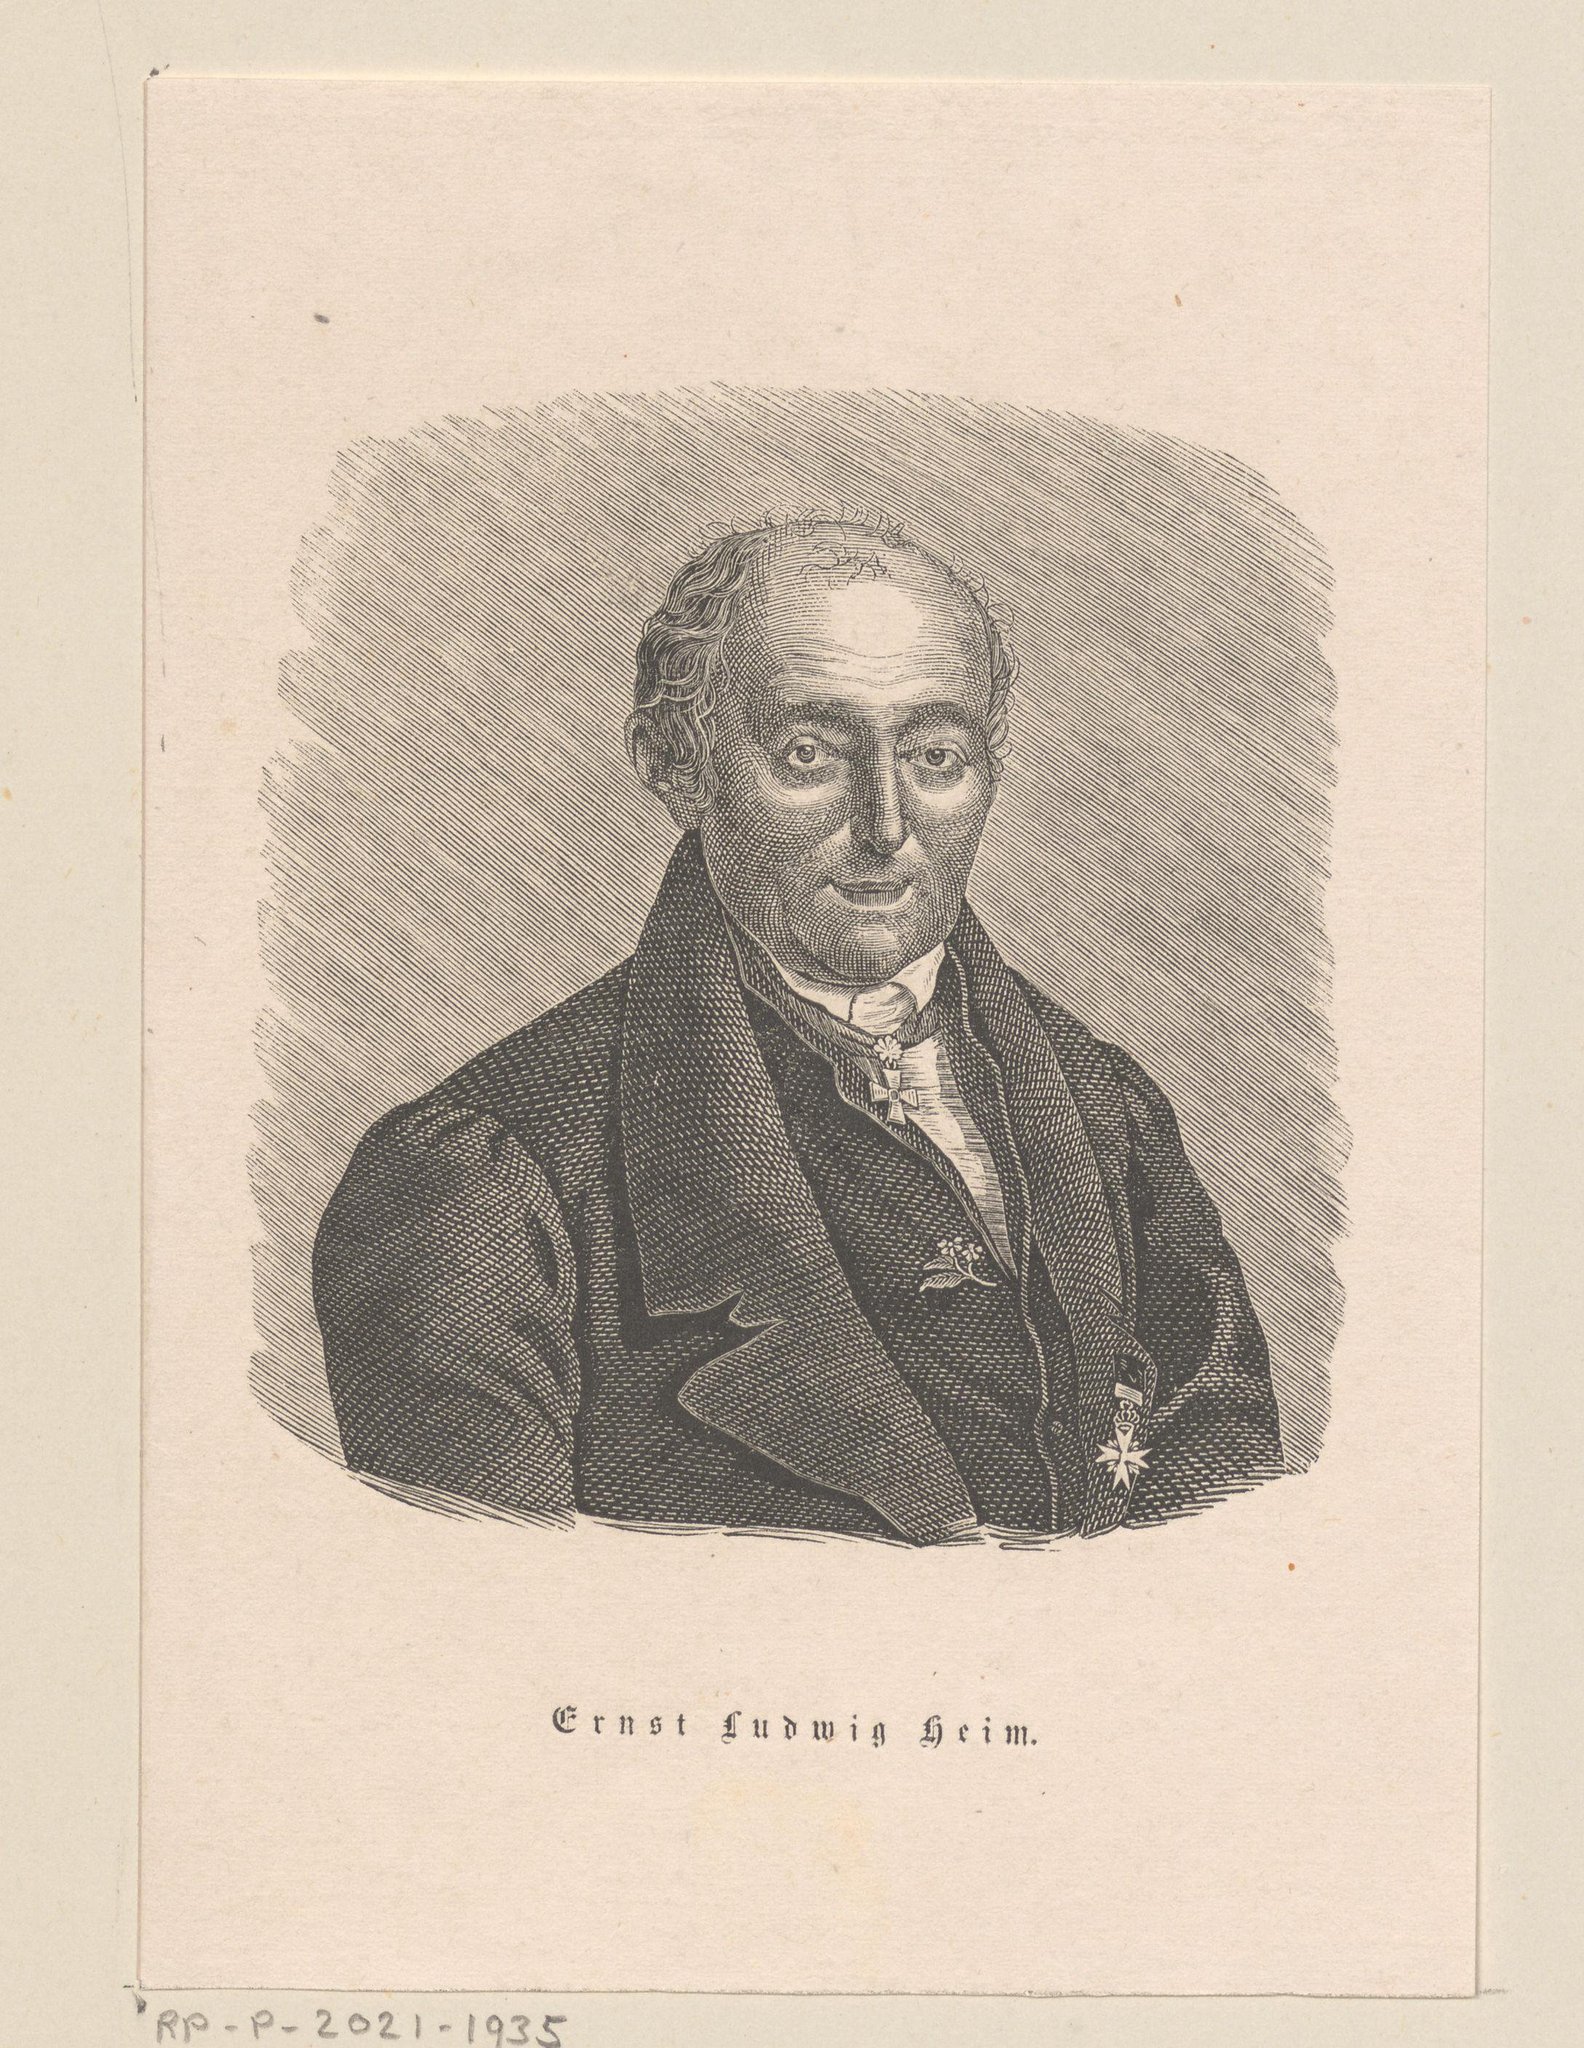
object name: print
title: Portret van Ernst Ludwig Heim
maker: Anonymous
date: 1850-1899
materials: paper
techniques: letterpress printing, engraving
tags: berlin, historical persons, physician, doctor